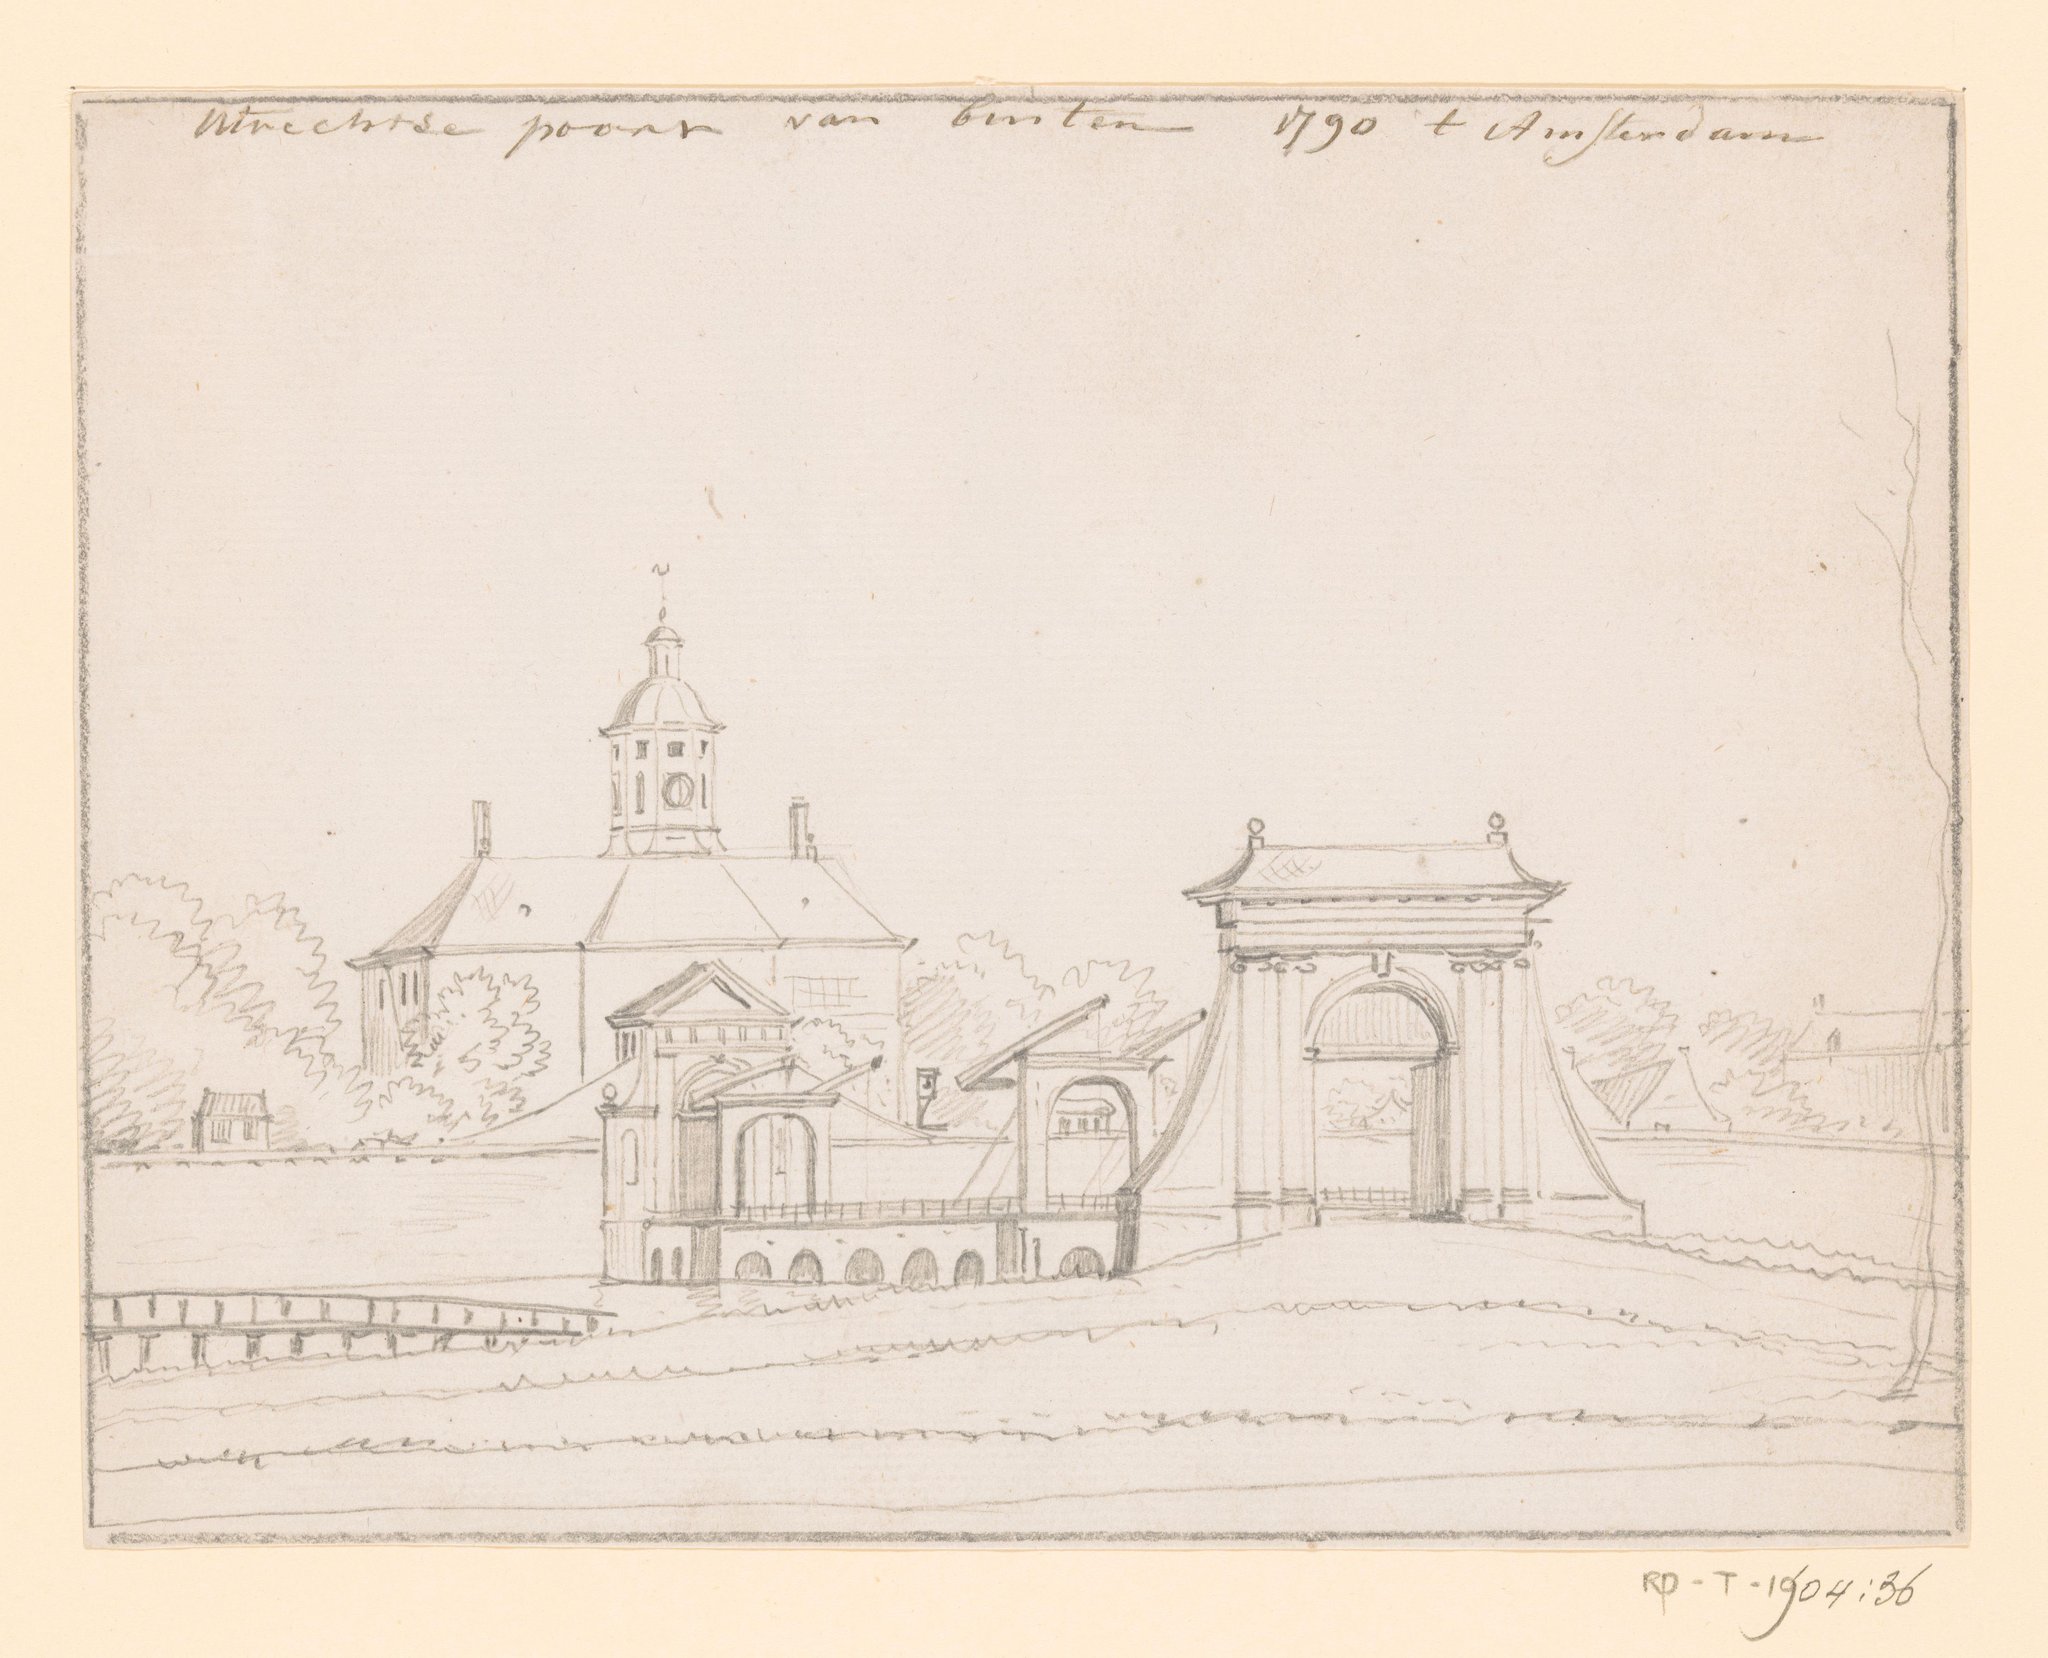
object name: drawing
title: Utrechtse poort van buiten 1790 t Amsterdam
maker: Anonymous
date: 1790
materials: ink, paper, pencil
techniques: pen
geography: amsterdam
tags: bridge in city across river, canal, etc., city-gate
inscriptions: collector's mark: Lugt 2228